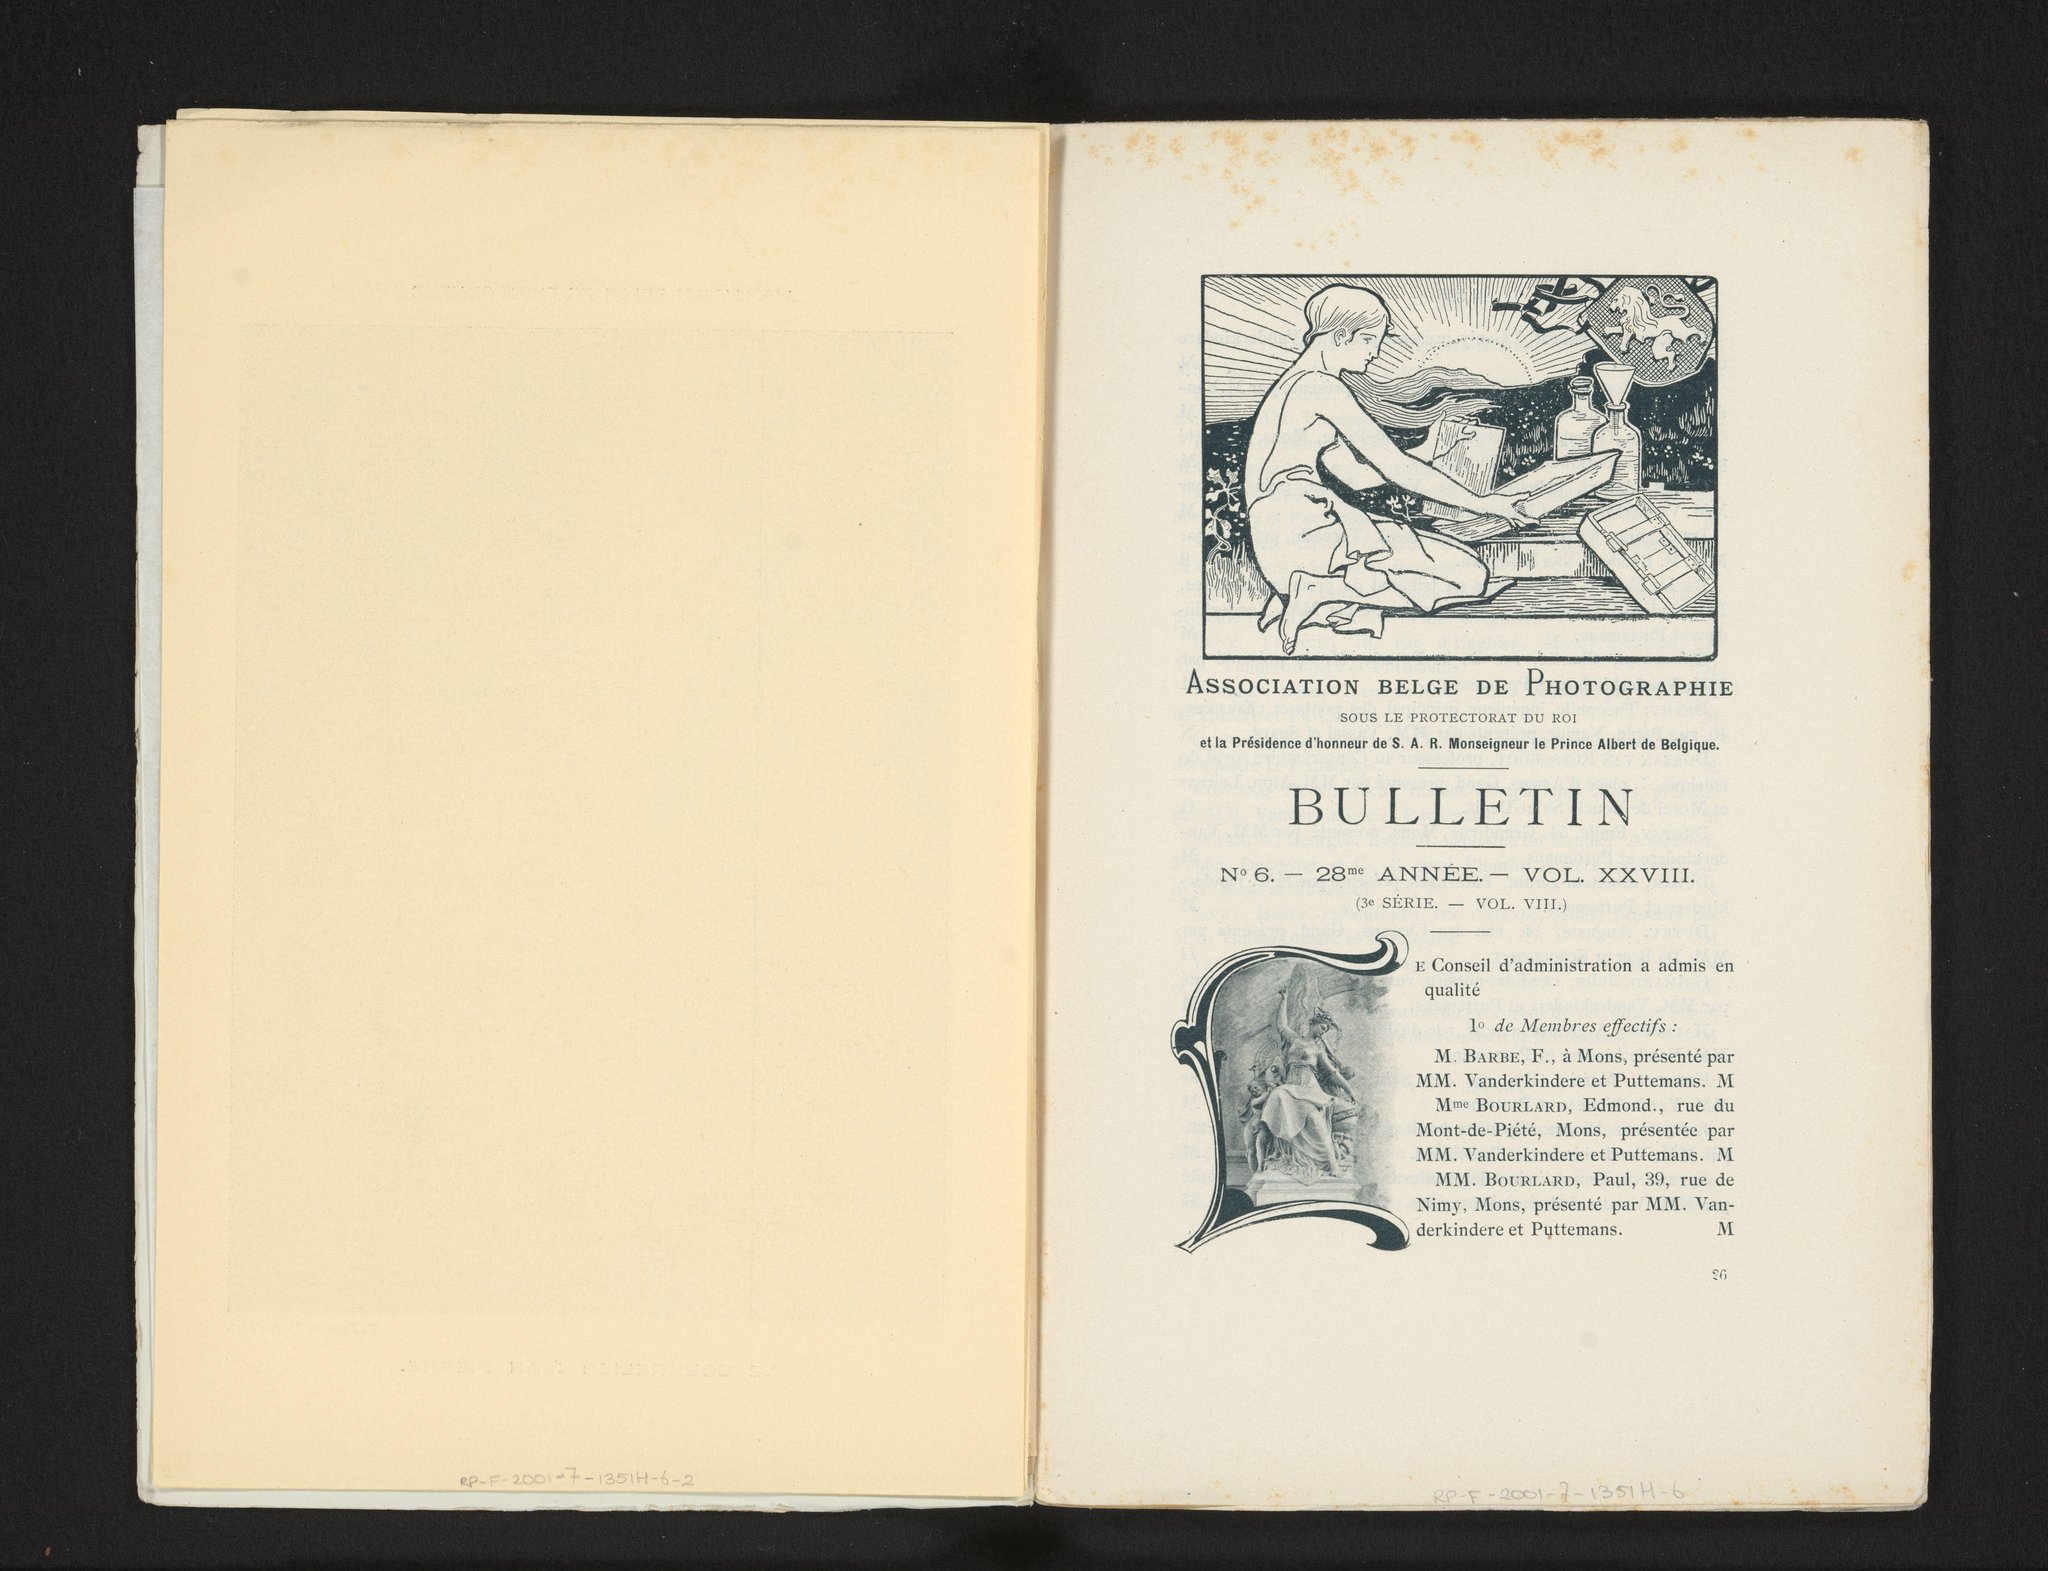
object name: book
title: Bulletin / Association belge de photographie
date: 1901-1906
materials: paper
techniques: printing, engraving